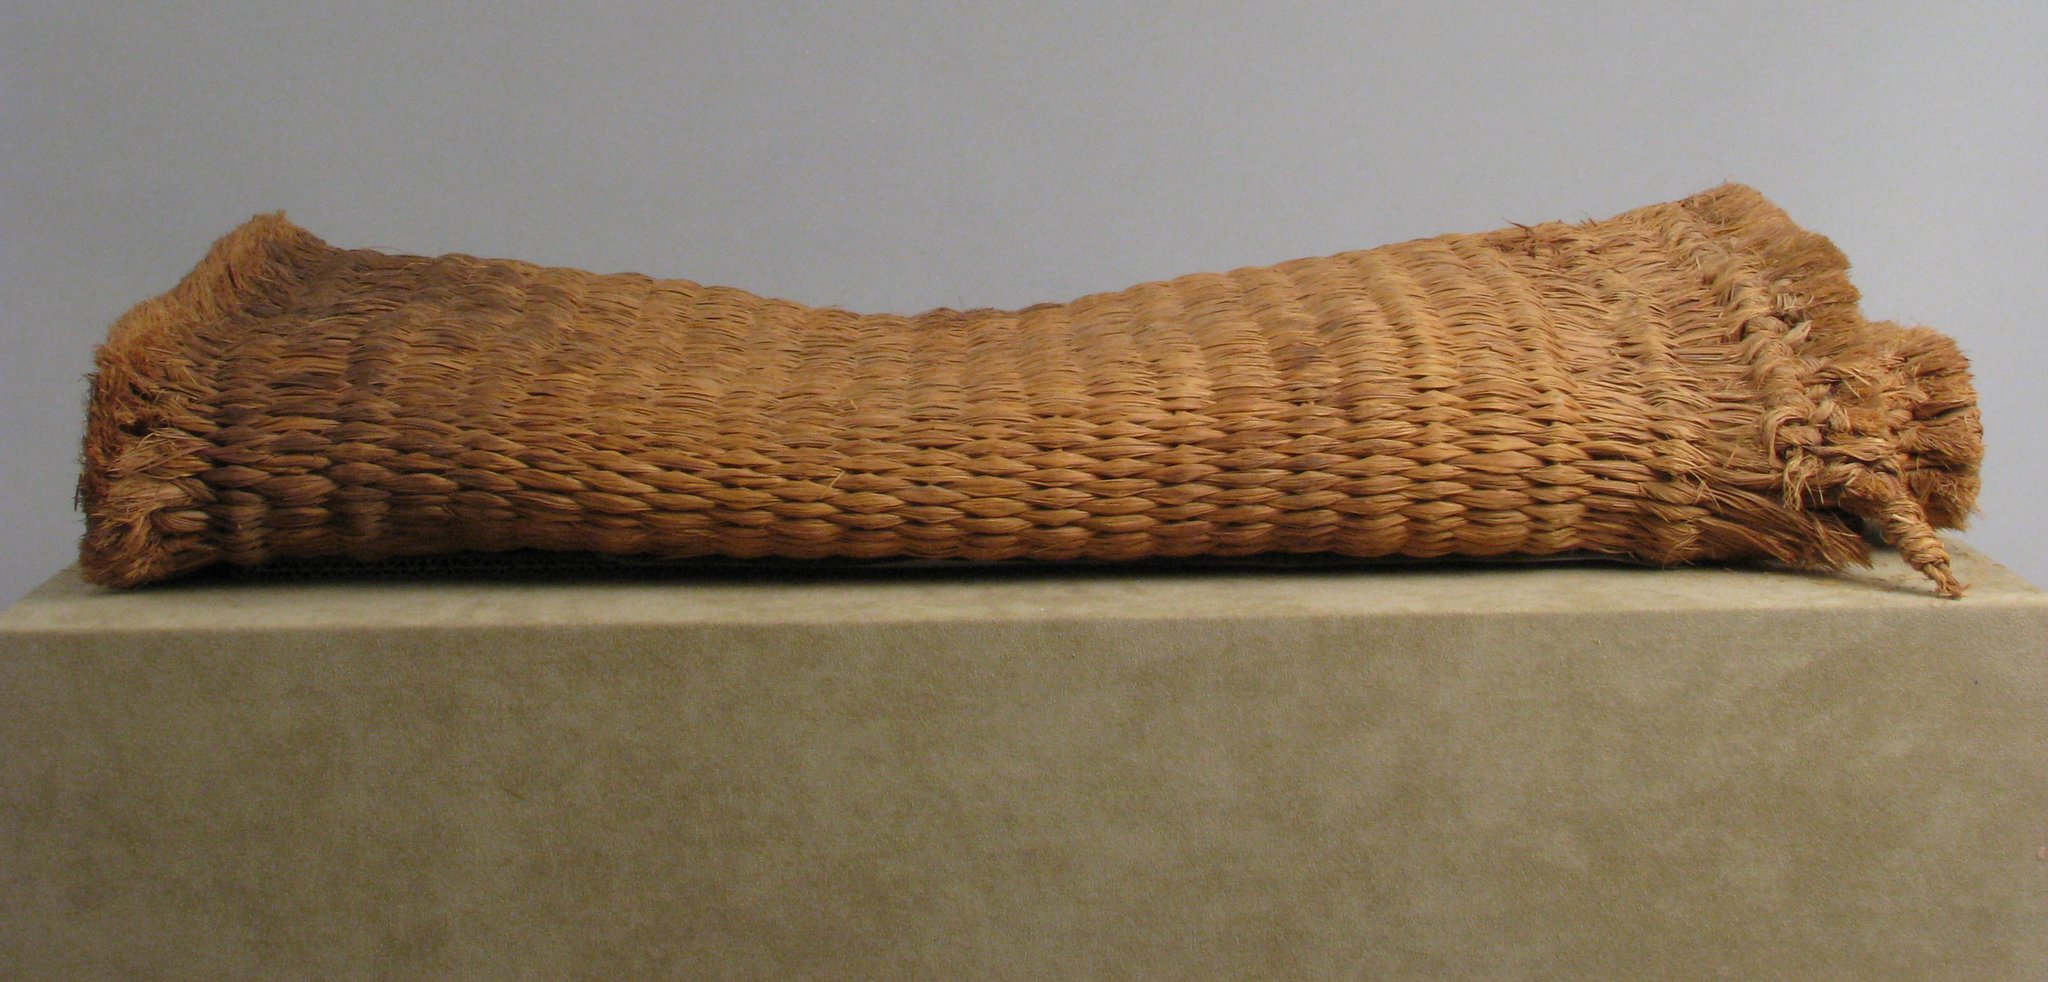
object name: mat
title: Woven Mat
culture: coptic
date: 500-600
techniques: weave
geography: egypt